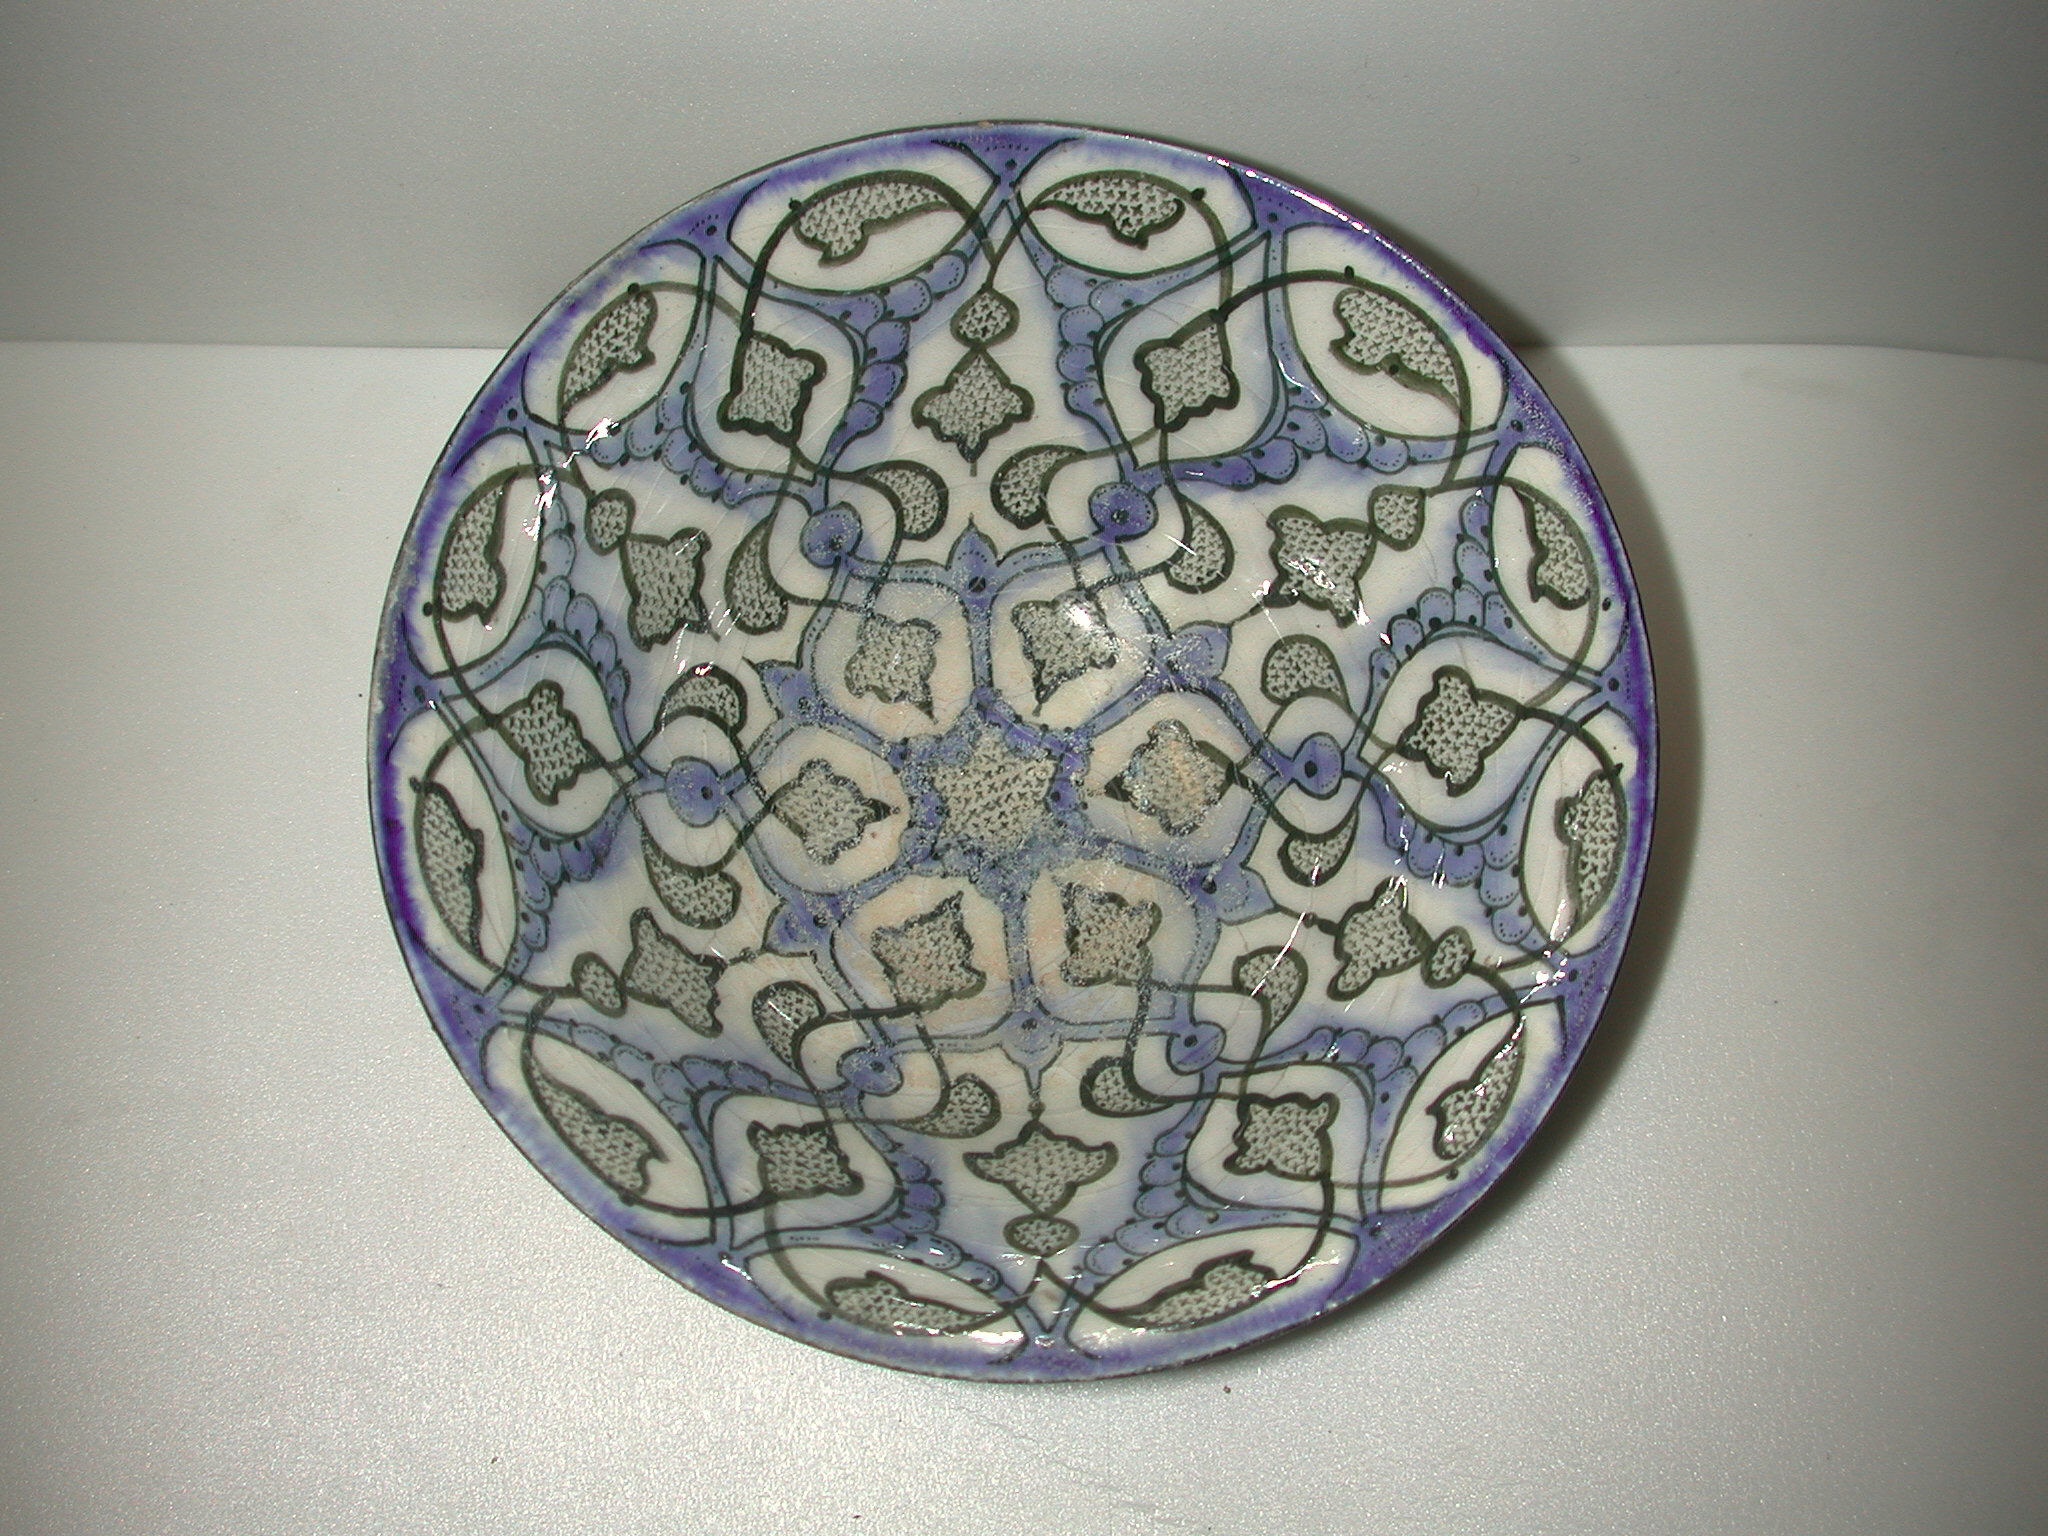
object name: bowl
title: Black and Blue Painted Bowl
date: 1201-1233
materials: glaze, stonepaste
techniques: painting, polychrome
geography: iran